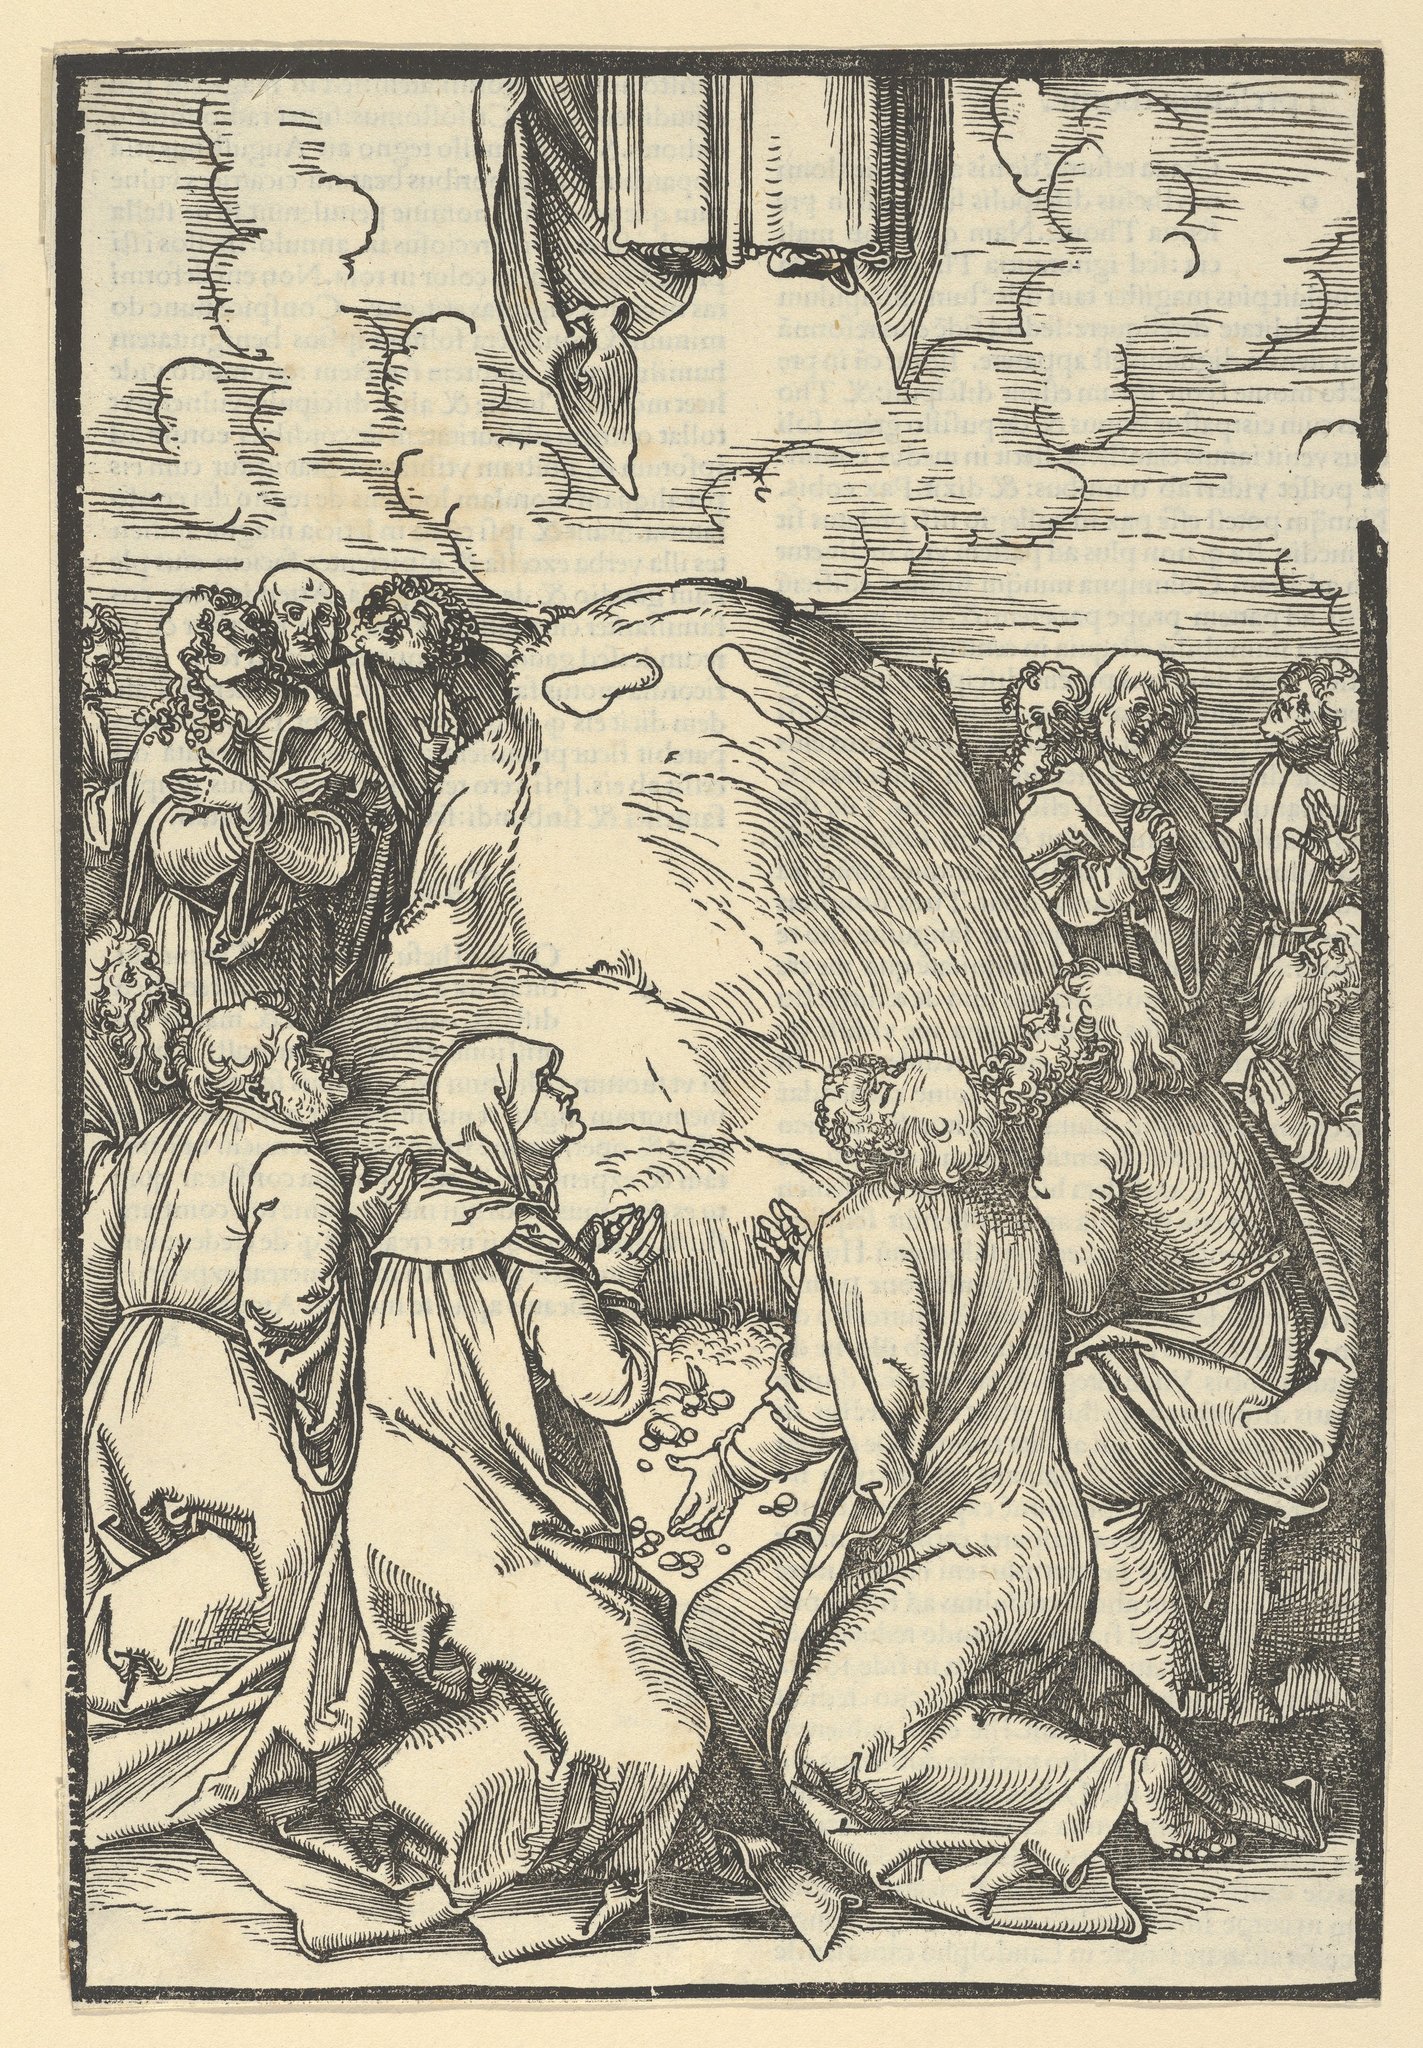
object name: print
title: The Ascension of Christ, from Speculum passionis domini nostri Ihesu Christi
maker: hans schäufelein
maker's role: artist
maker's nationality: german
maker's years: 1480-1540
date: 1507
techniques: woodcut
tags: men,women,saints